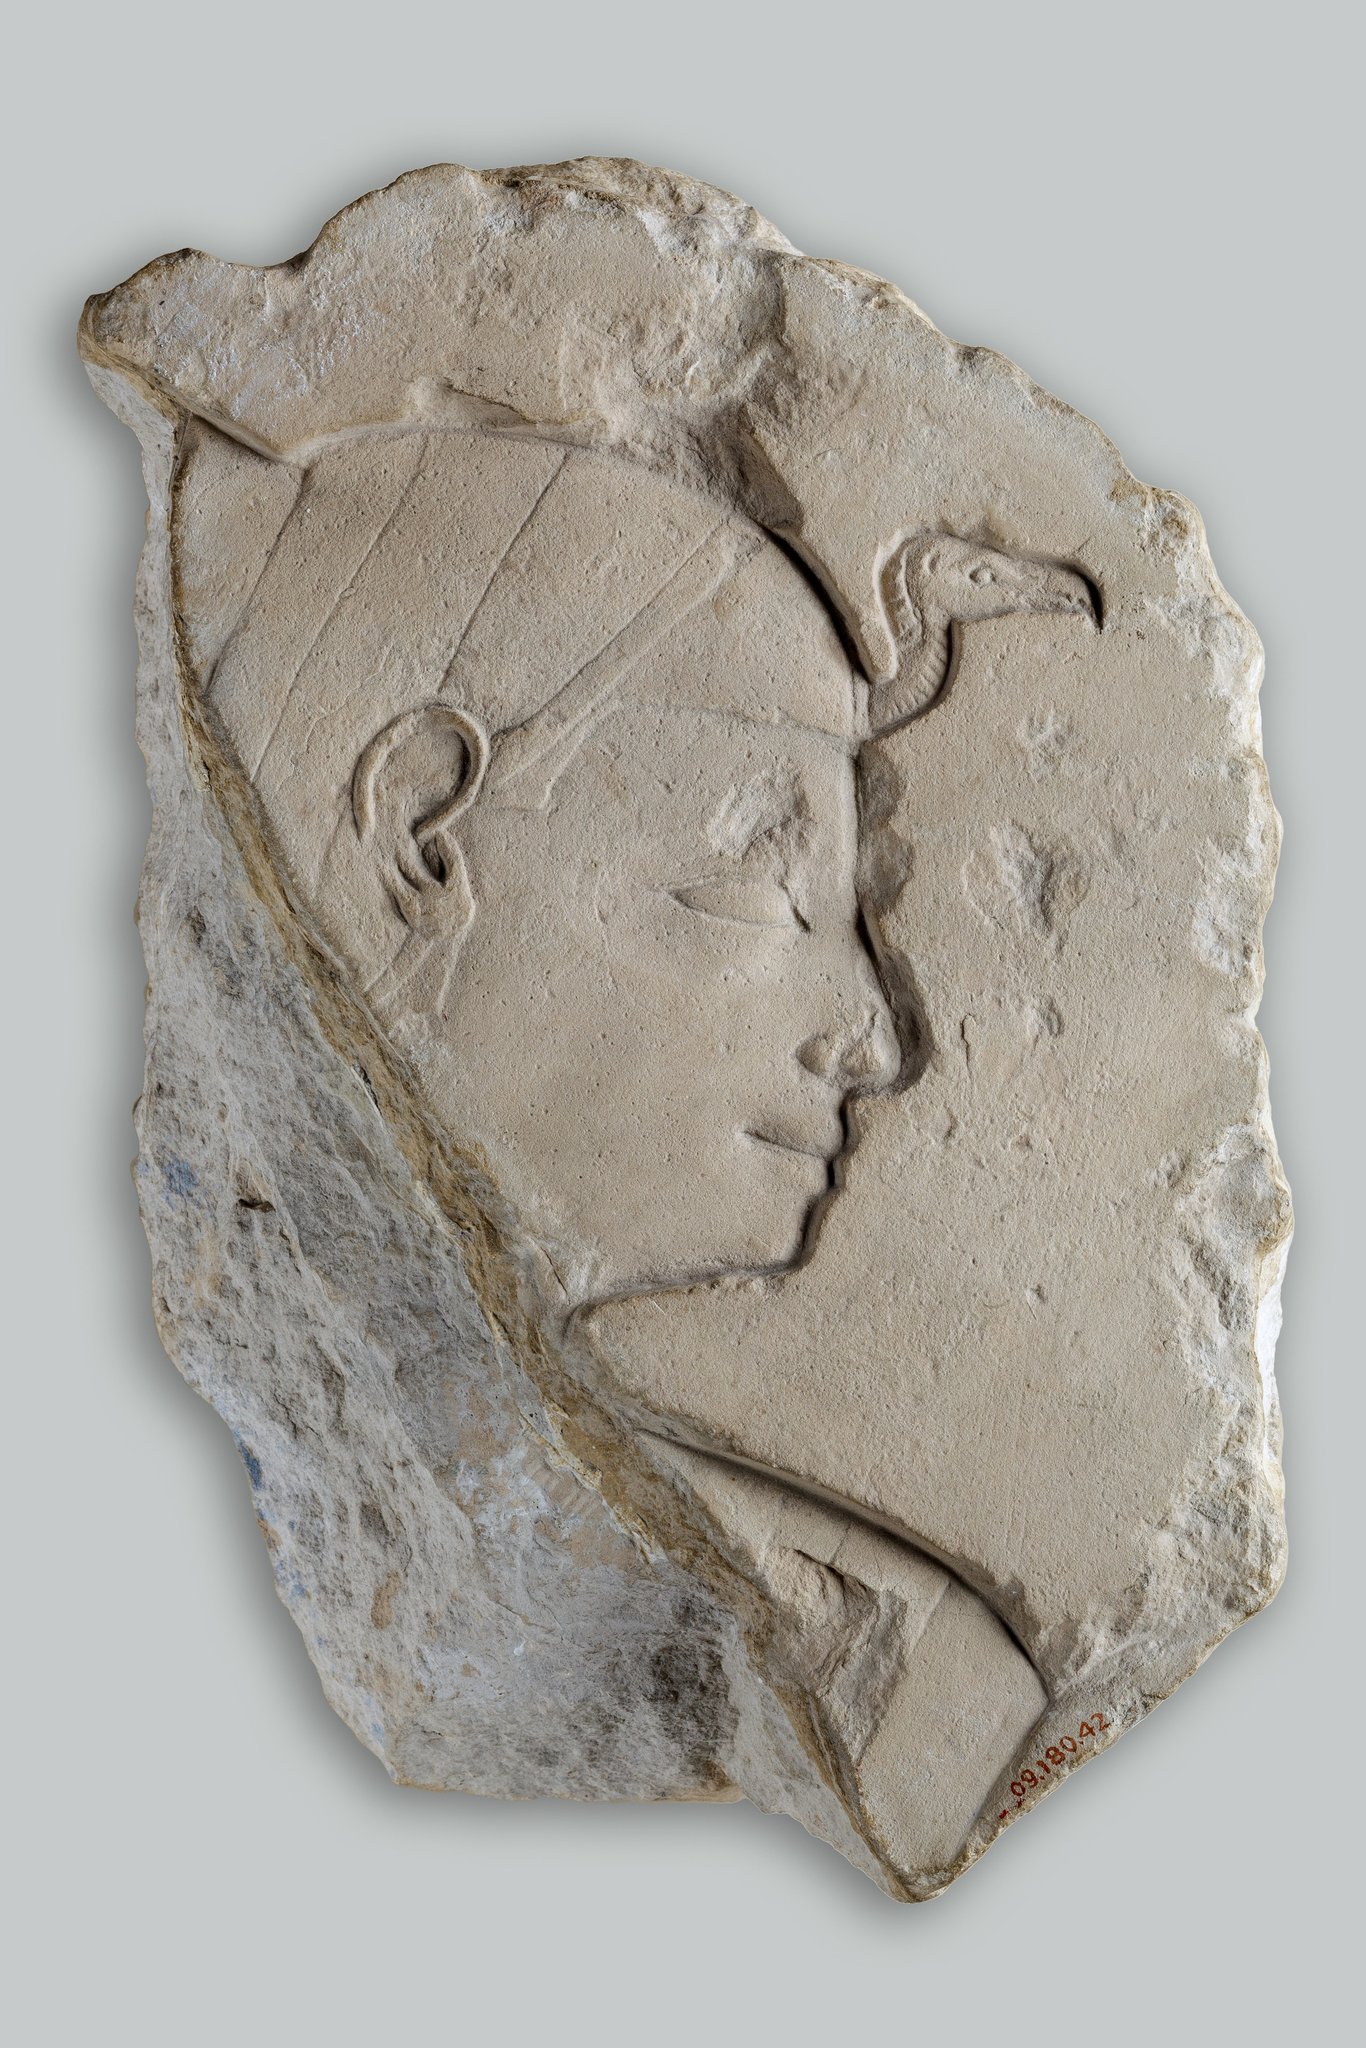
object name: relief, godess' head, queen's head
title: Relief with Head of a Goddess (or Queen)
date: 1961-1917 BCE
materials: limestone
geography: egypt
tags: queens,heads